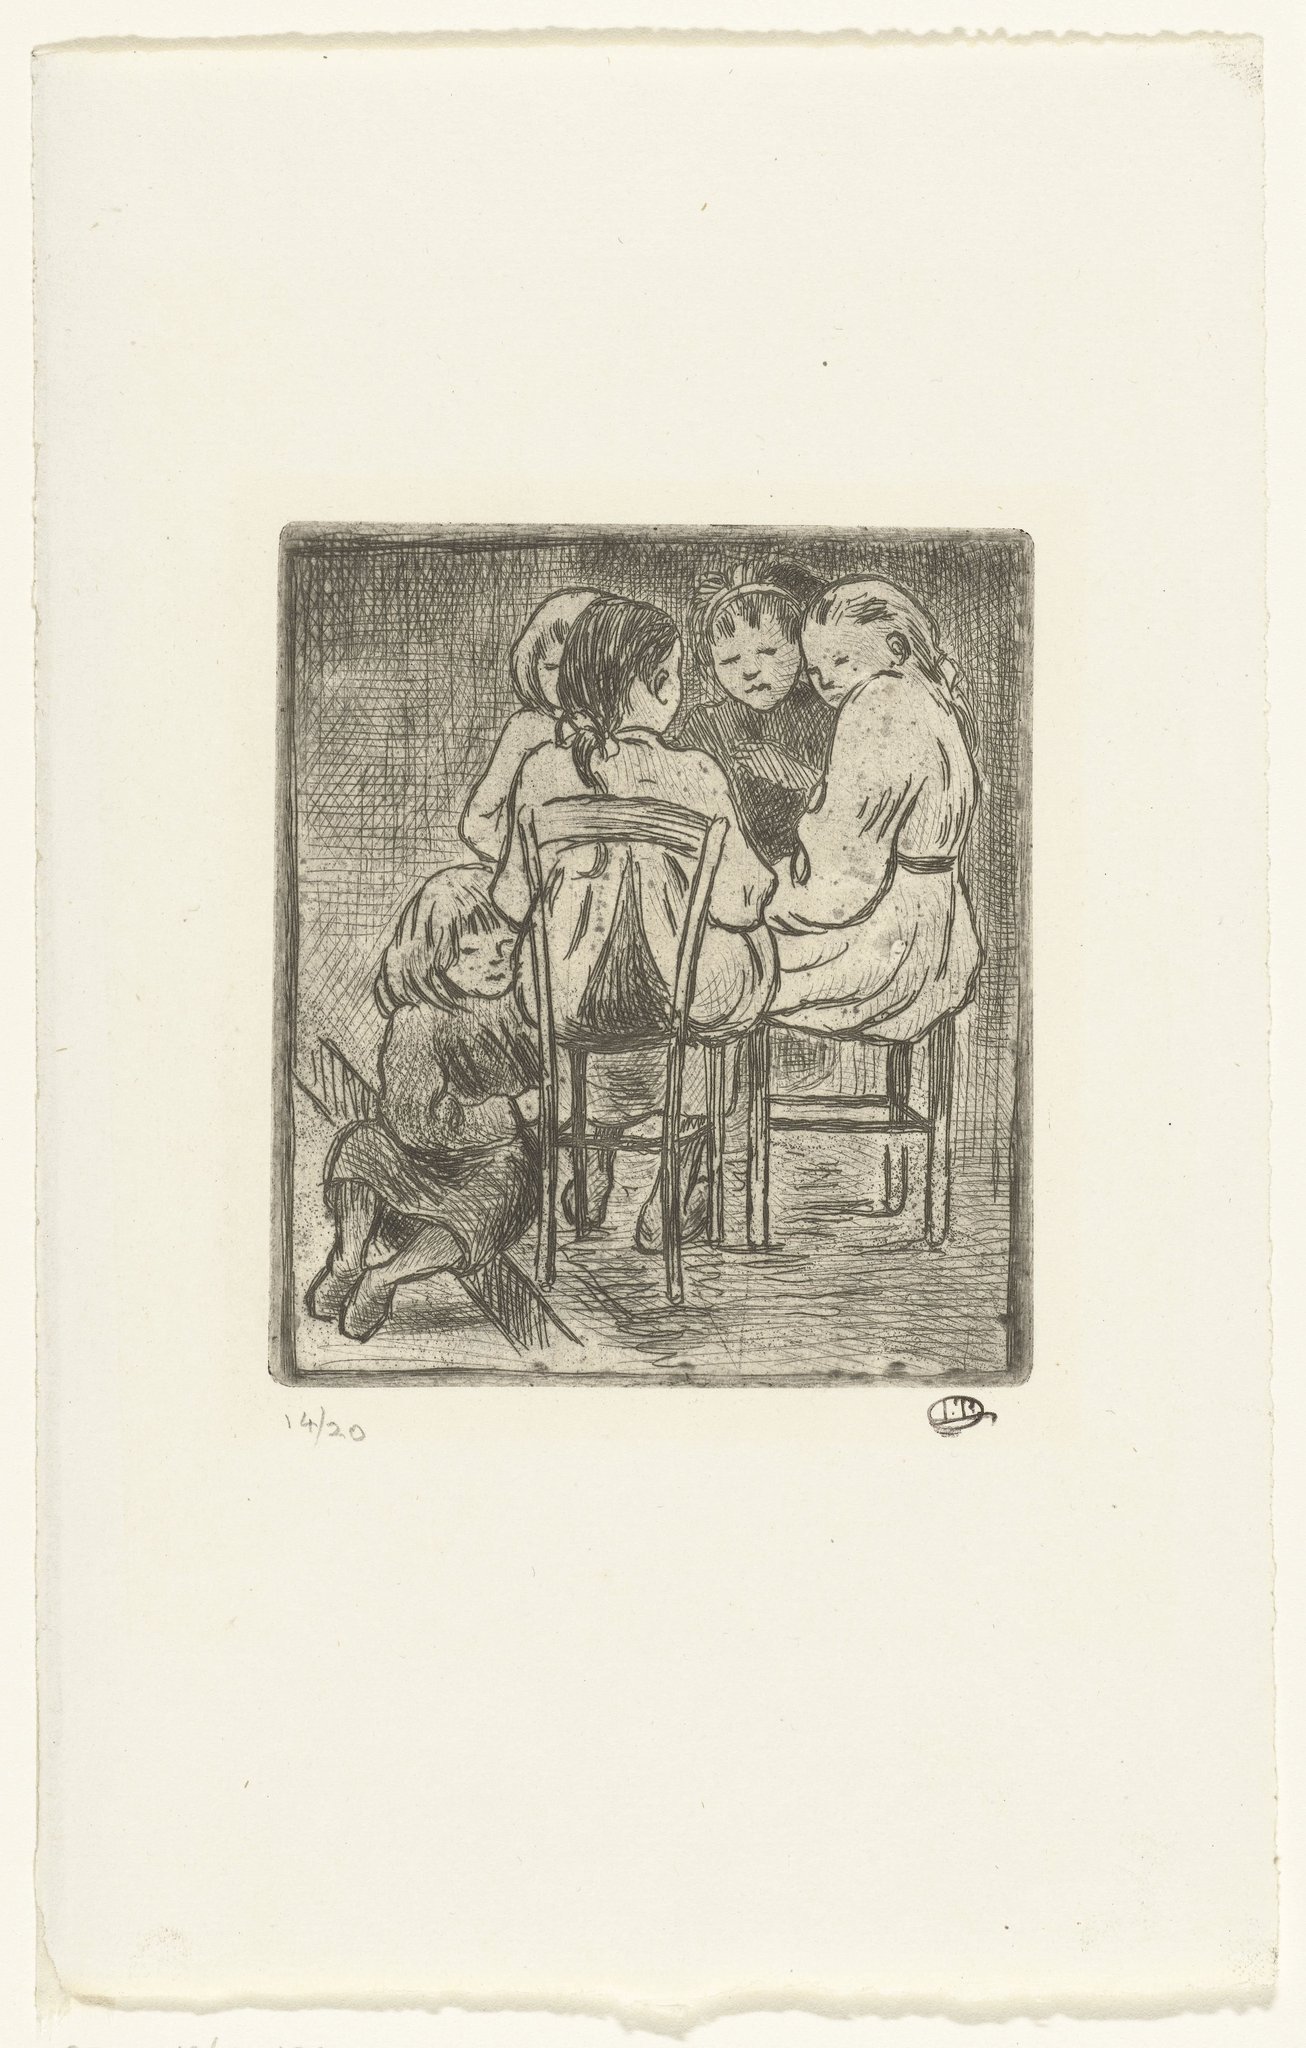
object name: print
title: Groep van vijf zittende meisjes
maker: lucien pissarro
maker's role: painter, print maker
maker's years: 1863-1944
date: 1873-1944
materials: paper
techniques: etching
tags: girl (child between toddler and youth) (+ five persons)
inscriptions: stamp: Lugt 1756b, collector's mark: Lugt 2228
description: Een groep van vijf meisjes in een kring, vier zittend op een stoel en één op de grond.